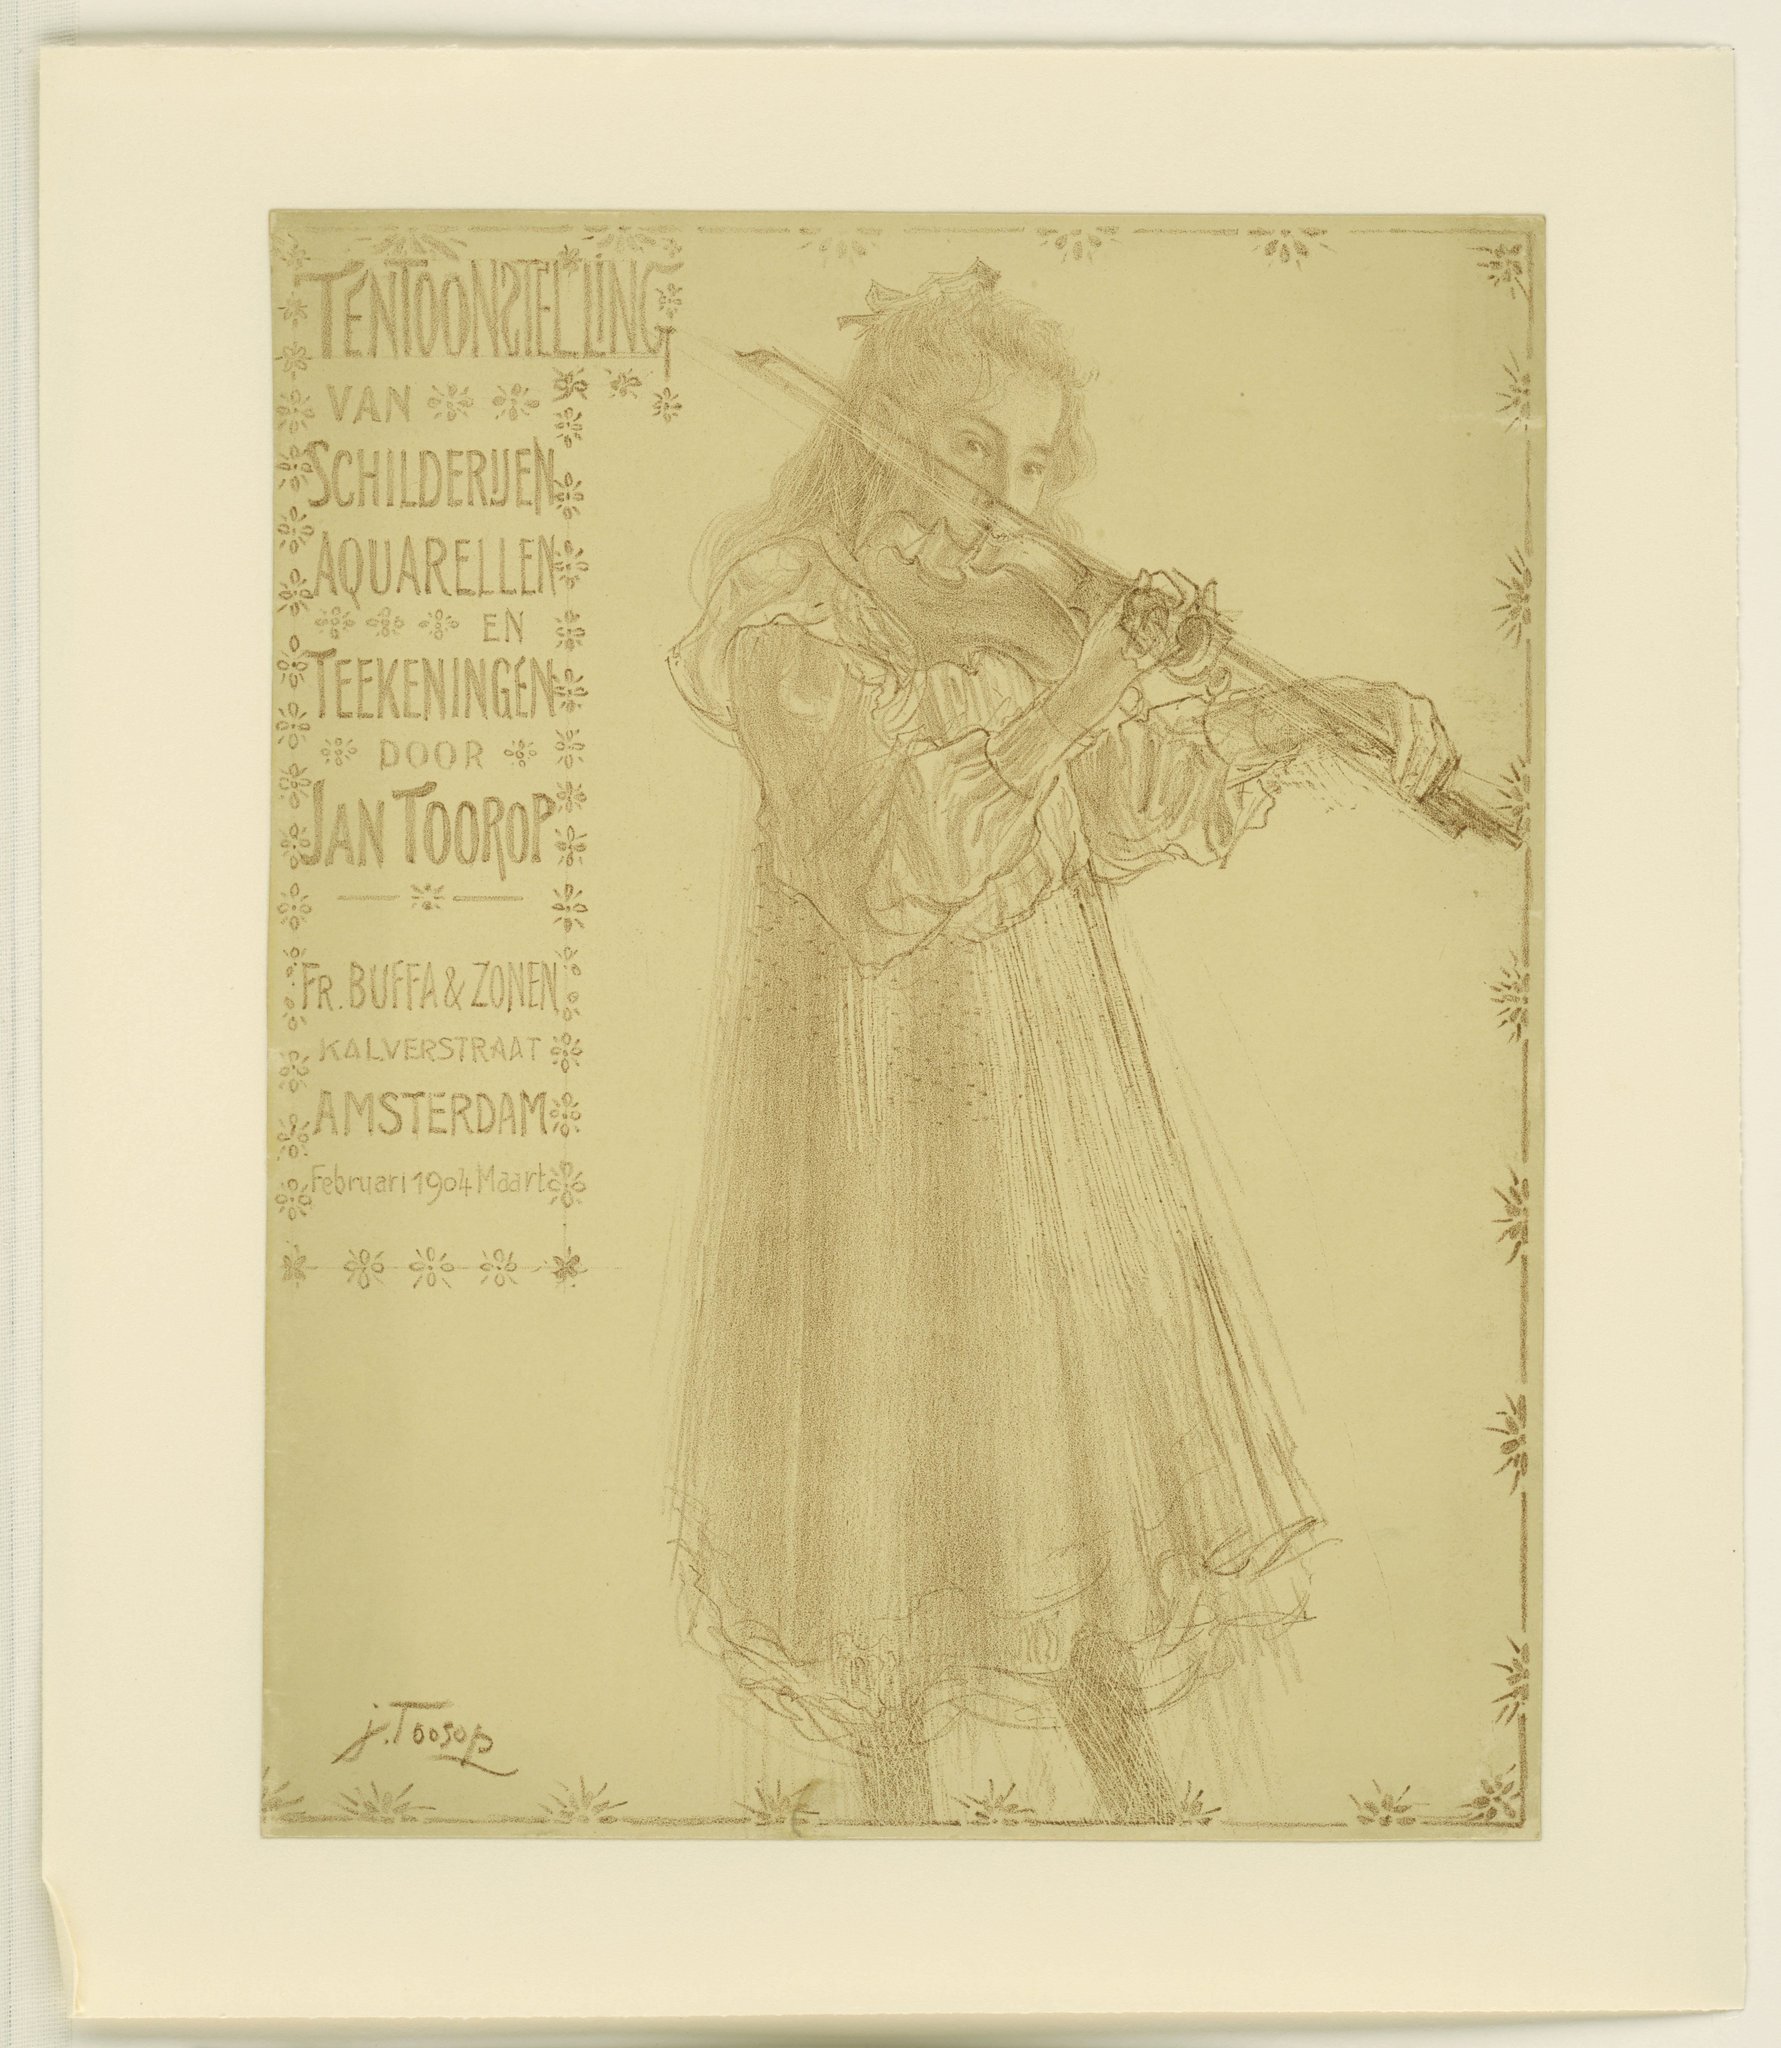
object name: wrapper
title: Girl Playing the Violin: Charley Toorop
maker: jan toorop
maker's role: draughtsman, painter, print maker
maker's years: 1858-1928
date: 1904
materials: paper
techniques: lithograph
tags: violin, fiddle, girl (child between toddler and youth), one person playing an instrument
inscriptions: collector's mark: Lugt 2760, collector's mark: Lugt 2228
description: Toorop designed the cover of the catalogue of a survey exhibition of his work at the art gallery Frans Buffa & Zonen in Amsterdam. Taking centre stage on the cover is his daughter Charley playing the violin. She studied at the conservatory in Paris for some time. Charley later also became a famous painter.